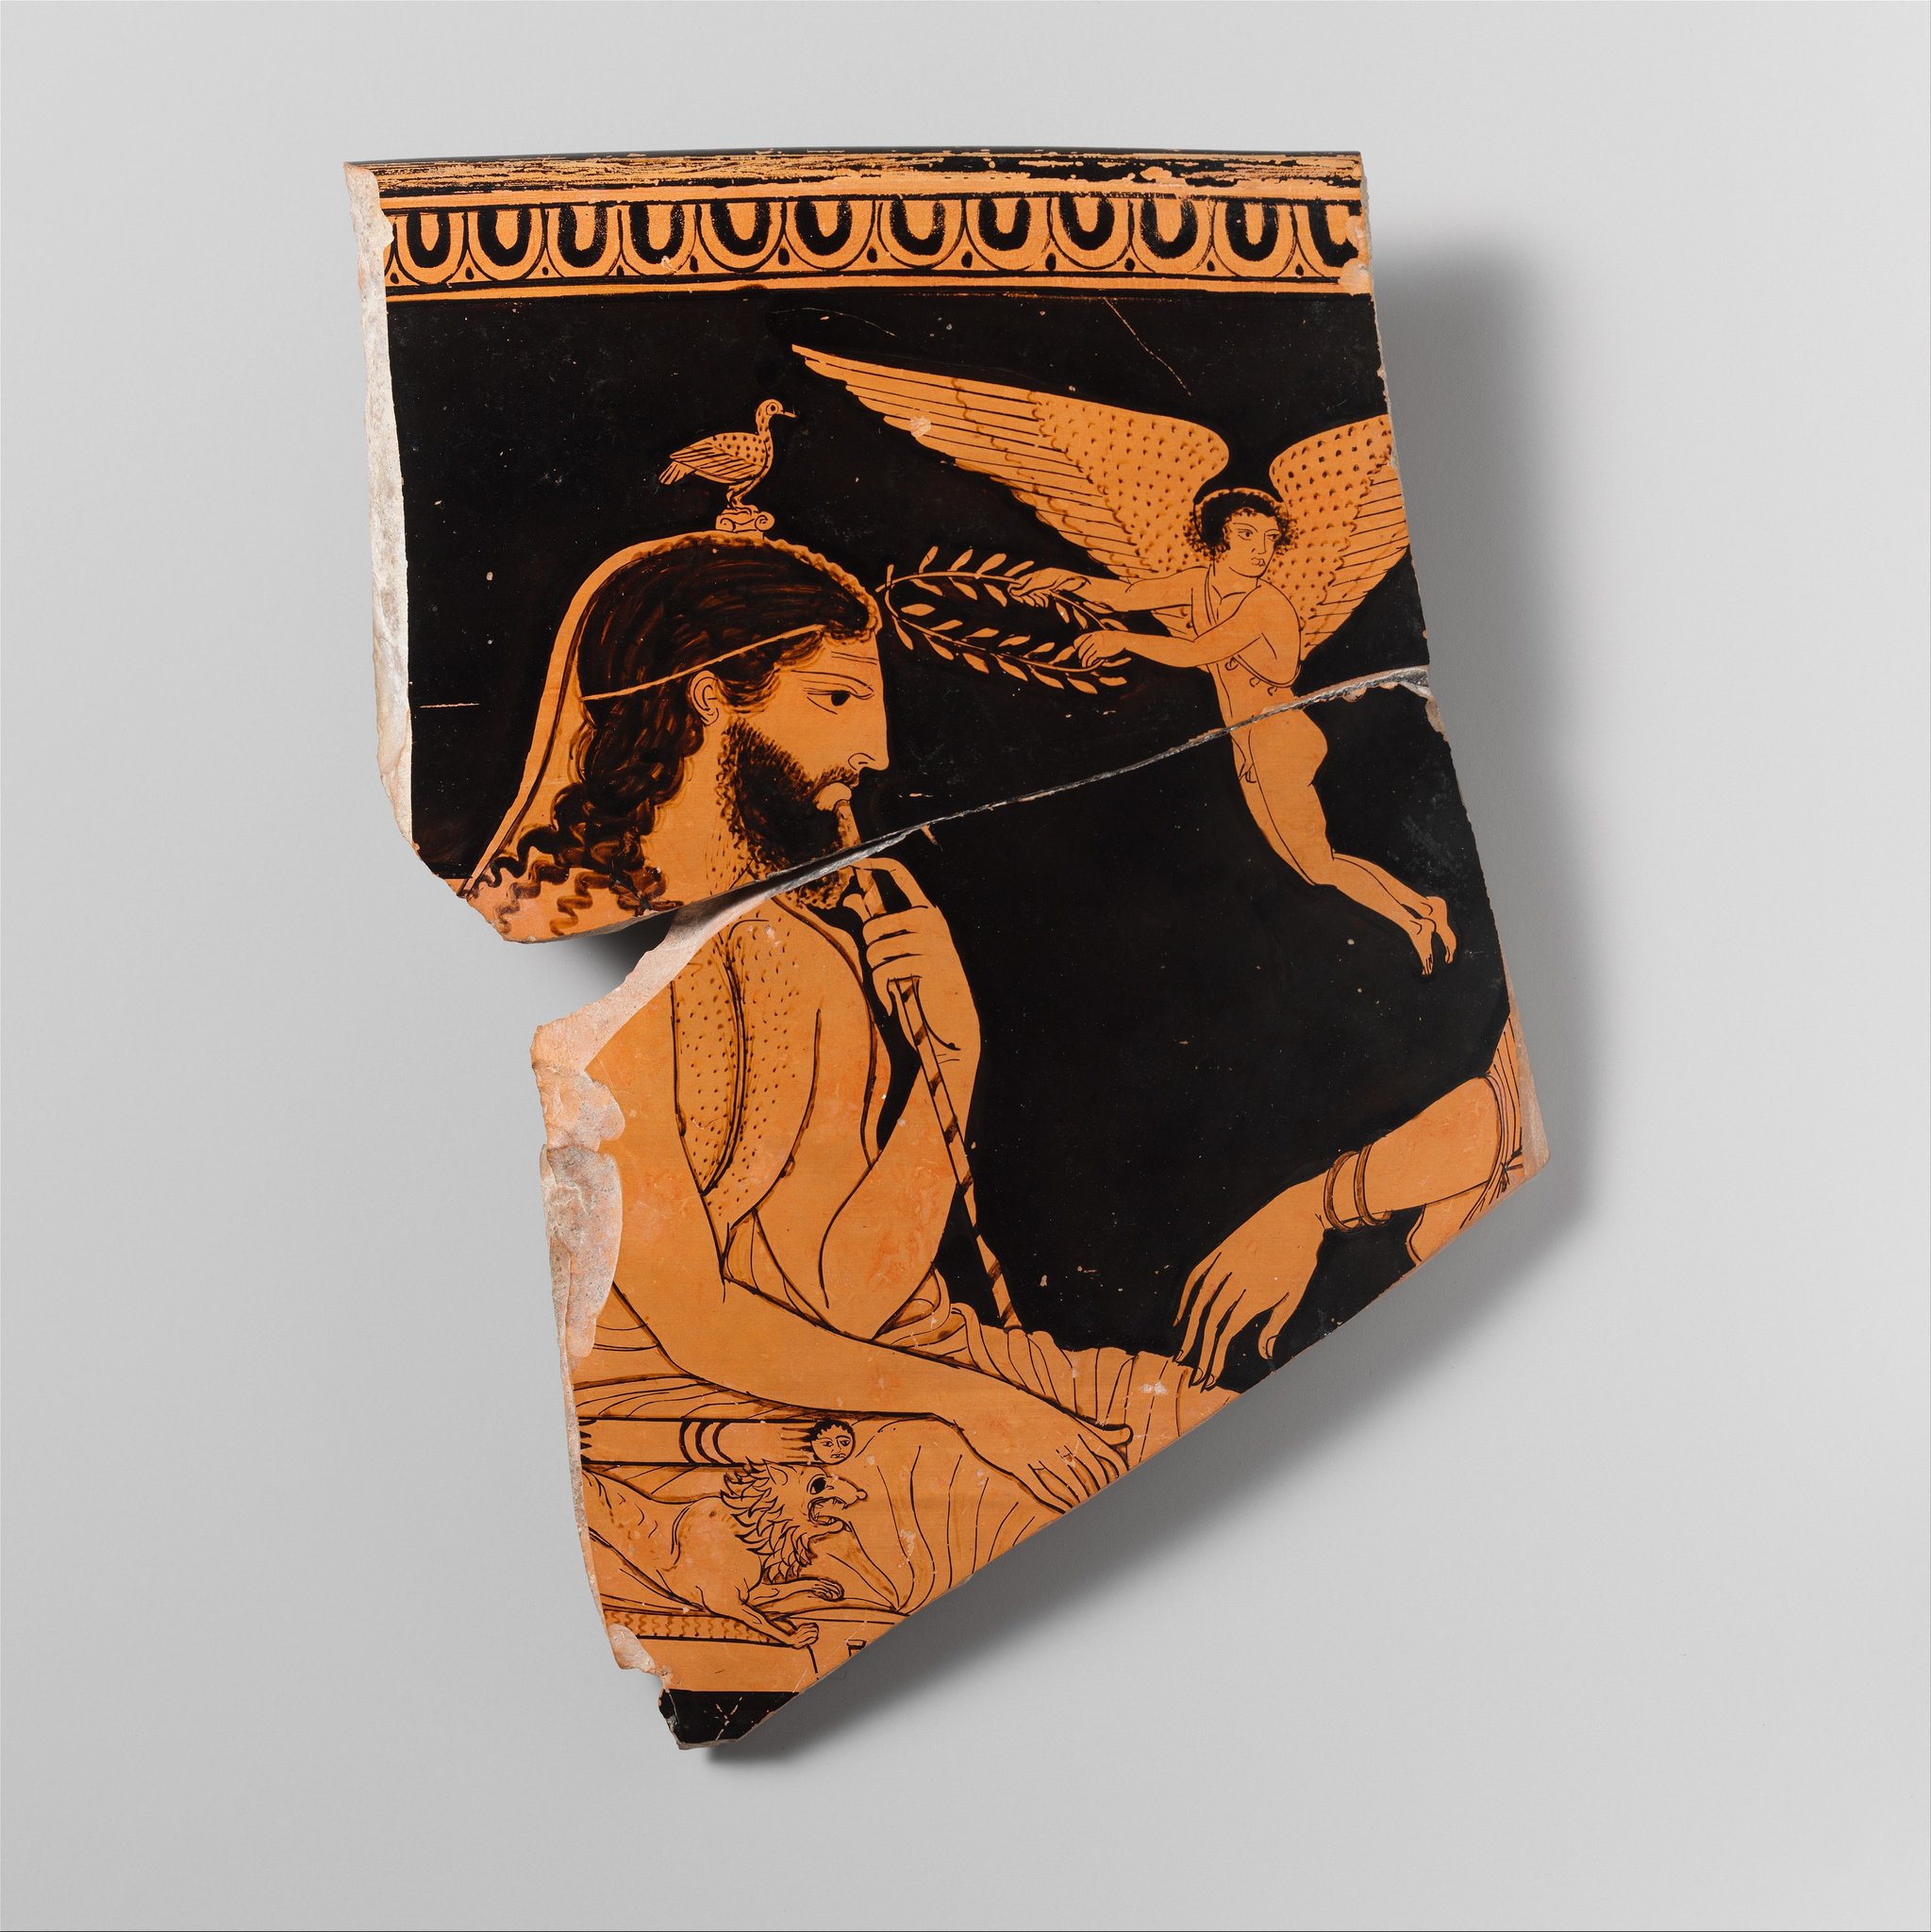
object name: skyphos fragment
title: Fragment of a terracotta skyphos (deep drinking cup)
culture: greek, south italian, lucanian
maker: palermo painter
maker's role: artist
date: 430-400 BCE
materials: terracotta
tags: eros,zeus,lions